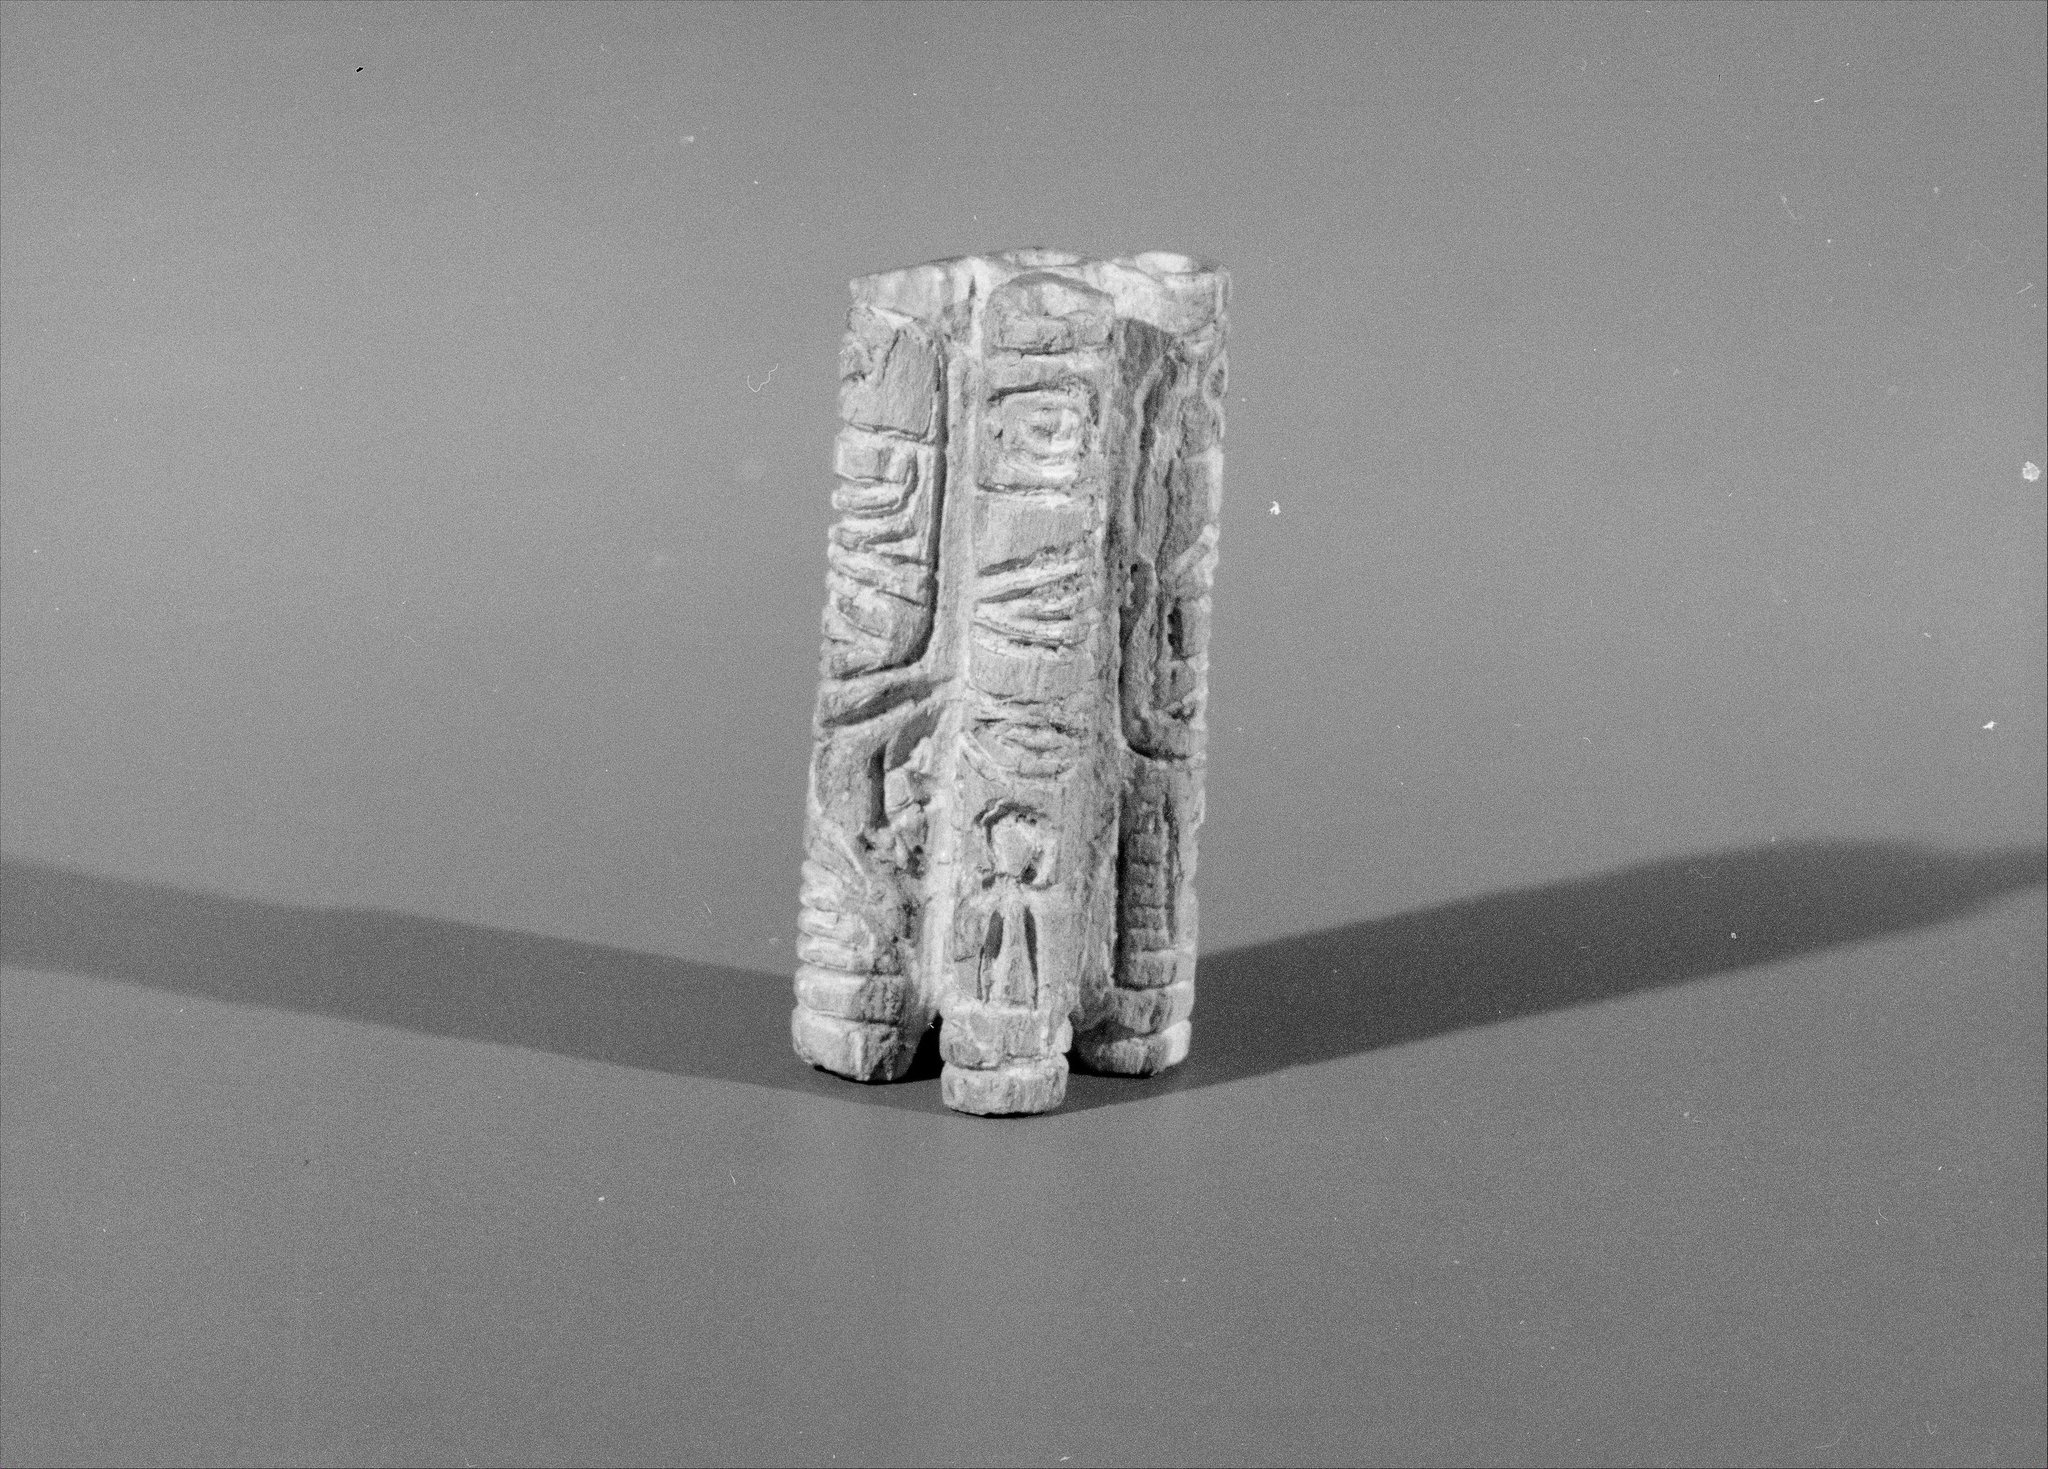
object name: cylinder seal, multiple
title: Multiple Cylinder Seal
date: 1648-1540 BCE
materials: stone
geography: eastern delta